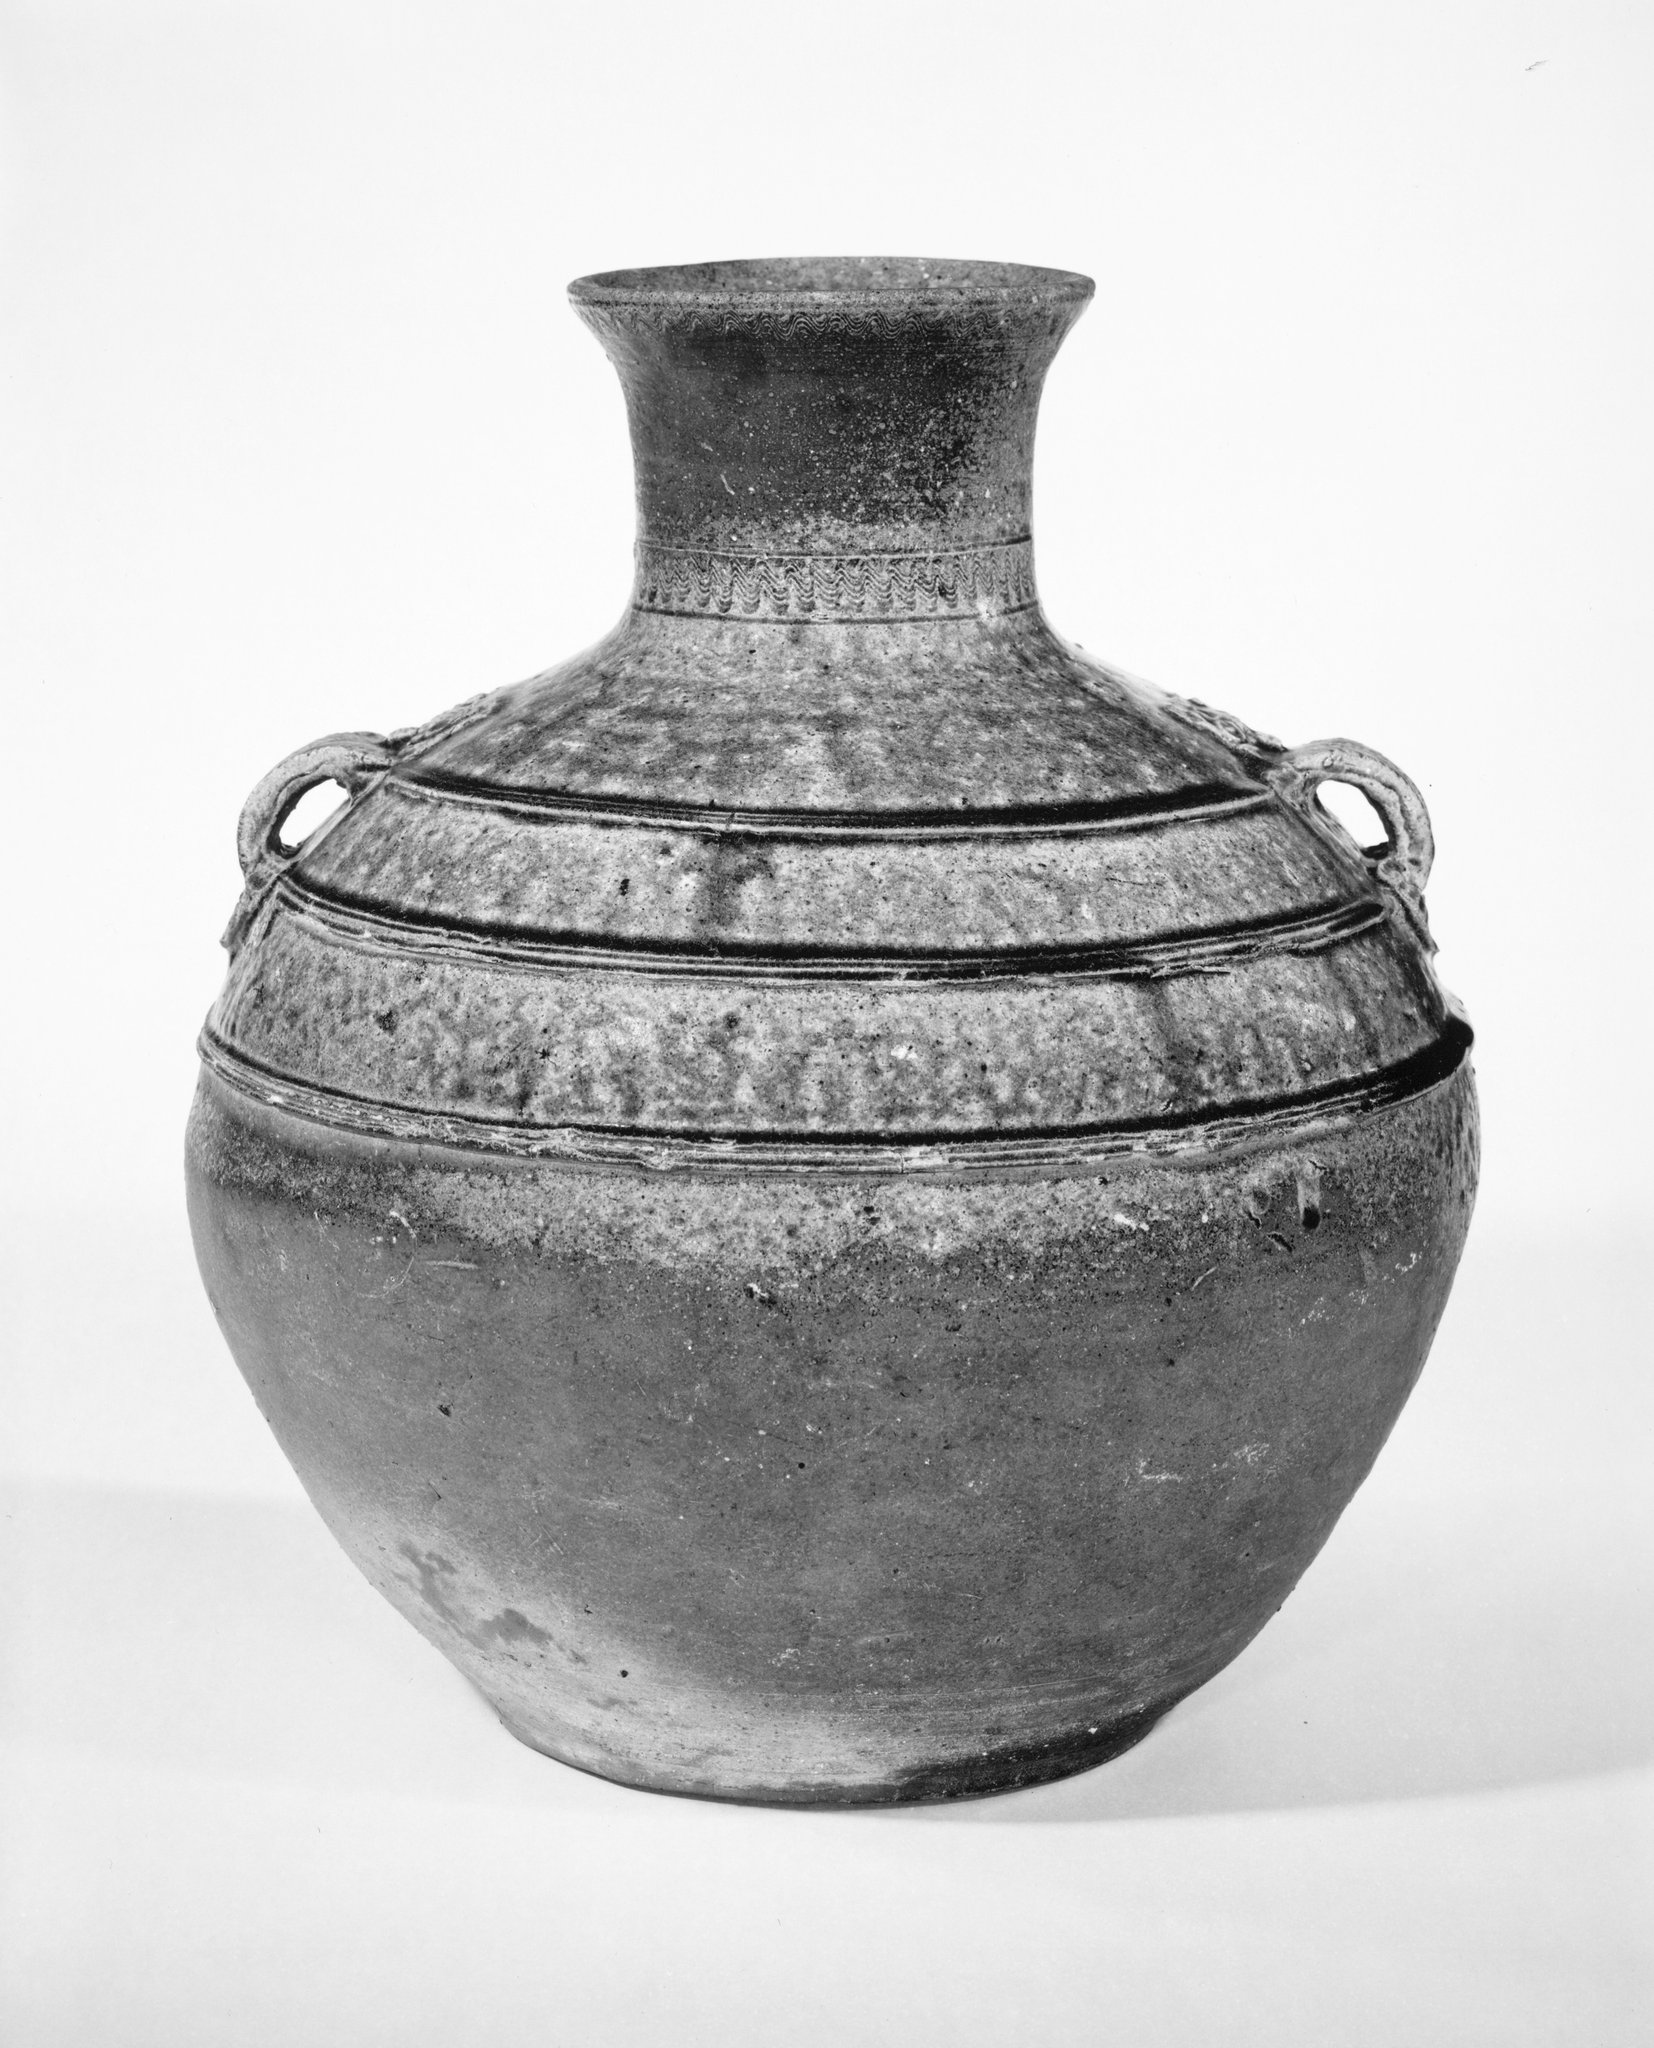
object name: jar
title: Jar (Labakou Hu)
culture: chinese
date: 100-1 BCE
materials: earthenware, glaze